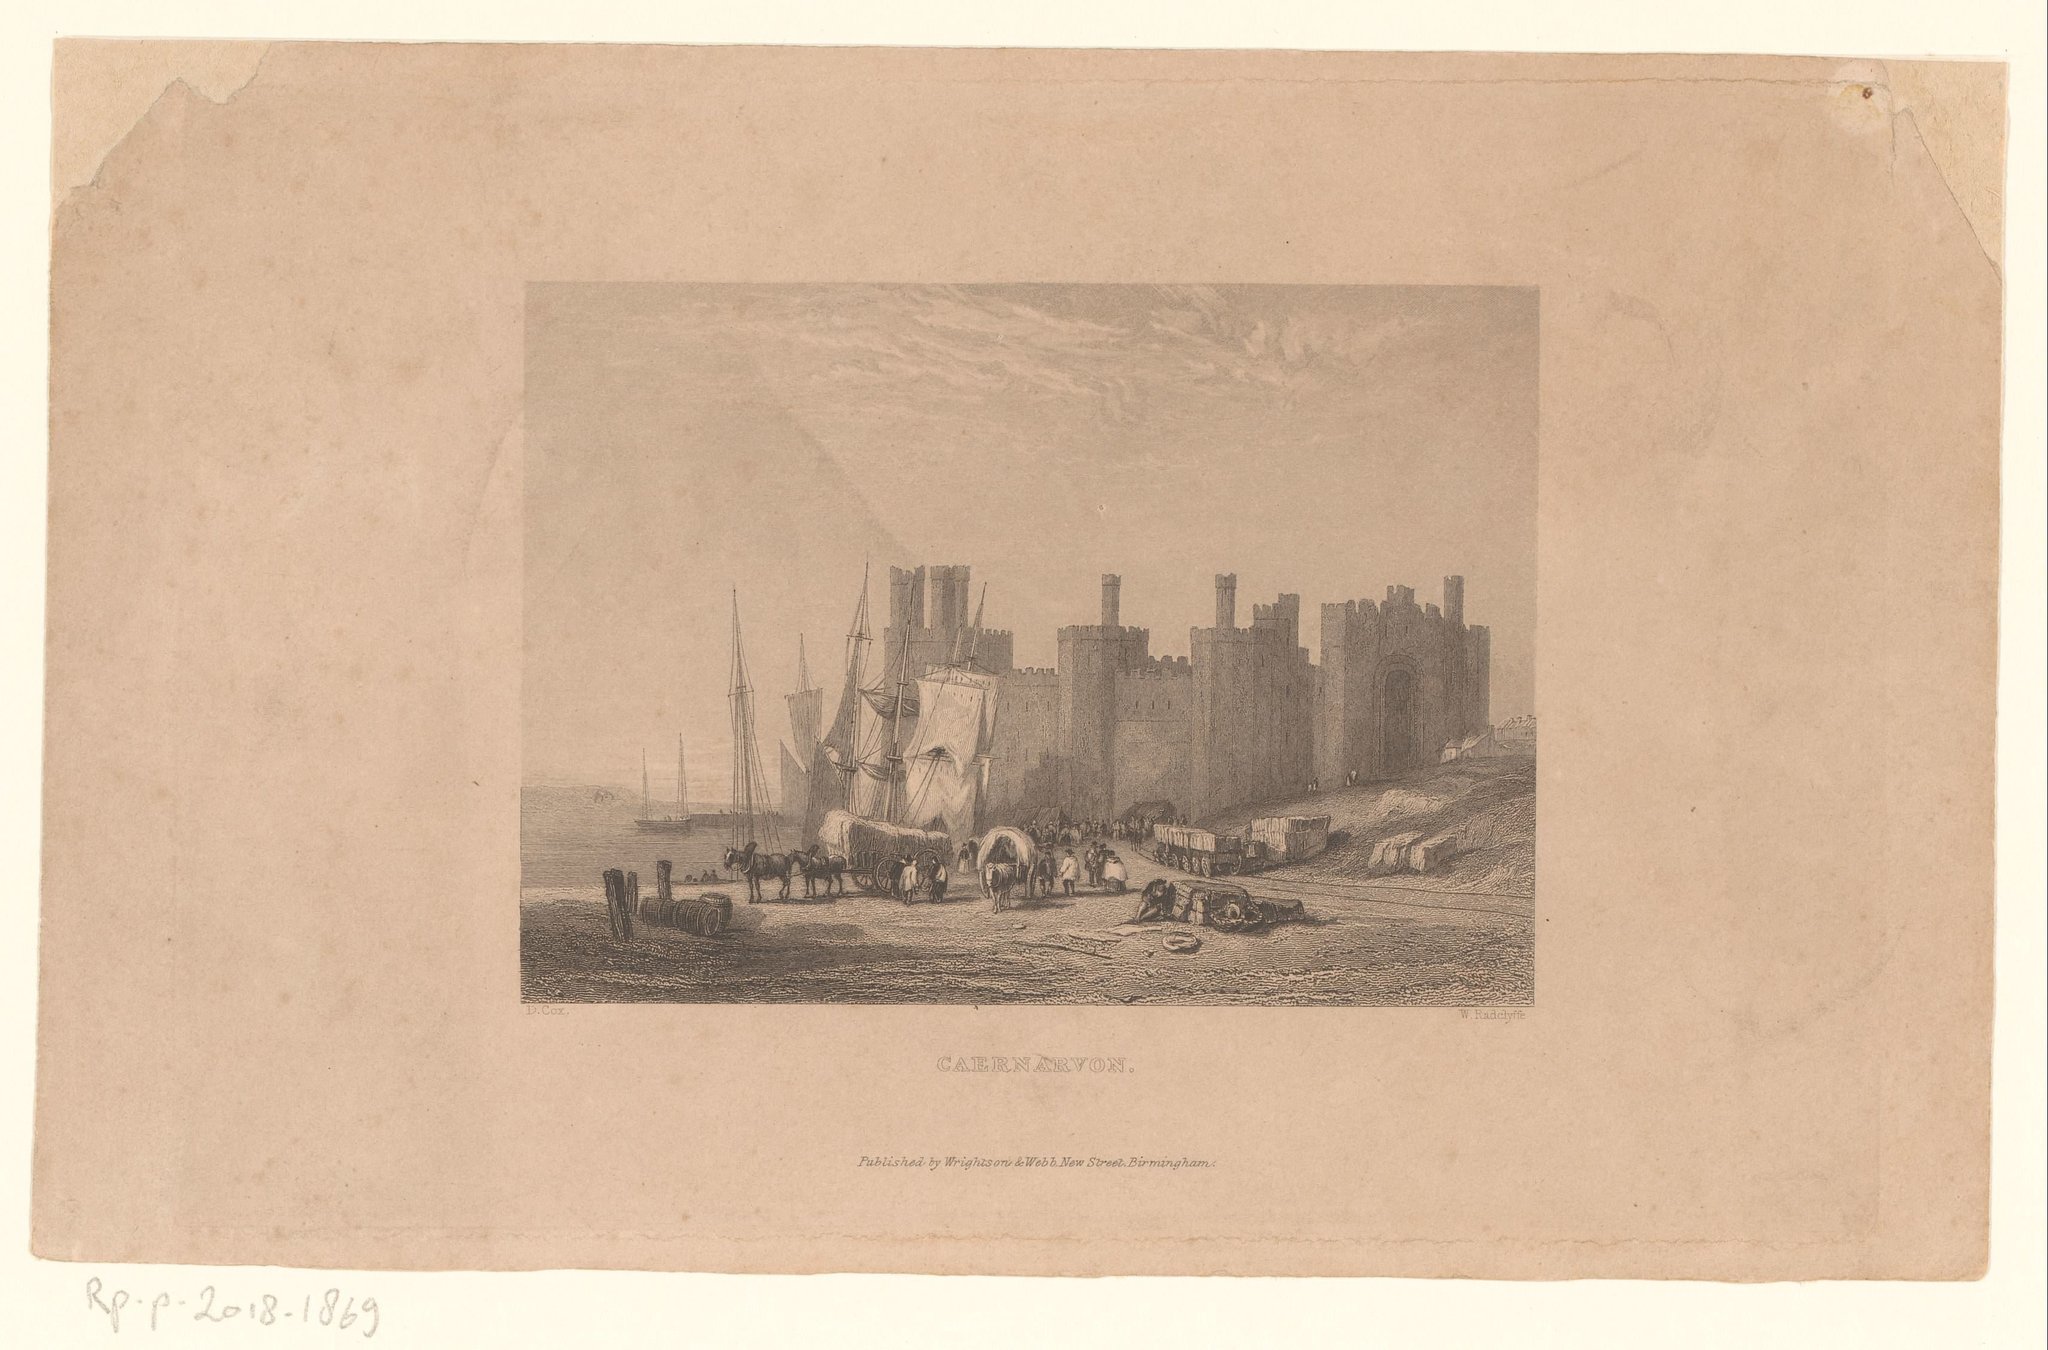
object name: print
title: Gezicht op Caernarfon Castle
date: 1839-1847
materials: paper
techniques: etching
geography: birmingham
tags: castle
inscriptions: collector's mark: Lugt 2228